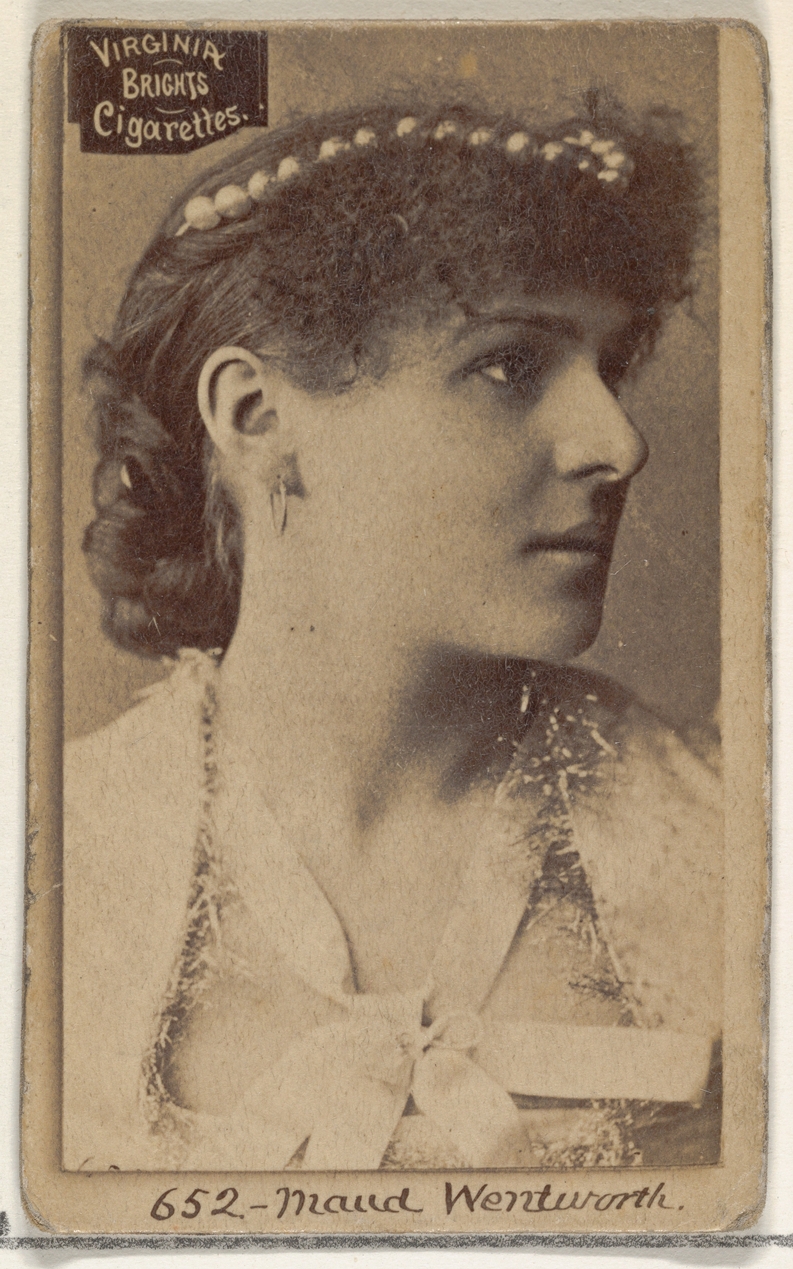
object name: photograph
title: Card 652, Maud Wentworth, from the Actors and Actresses series (N45, Type 2) for Virginia Brights Cigarettes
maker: allen & ginter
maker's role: publisher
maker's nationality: american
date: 1888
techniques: albumen silver print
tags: profiles,women,actresses